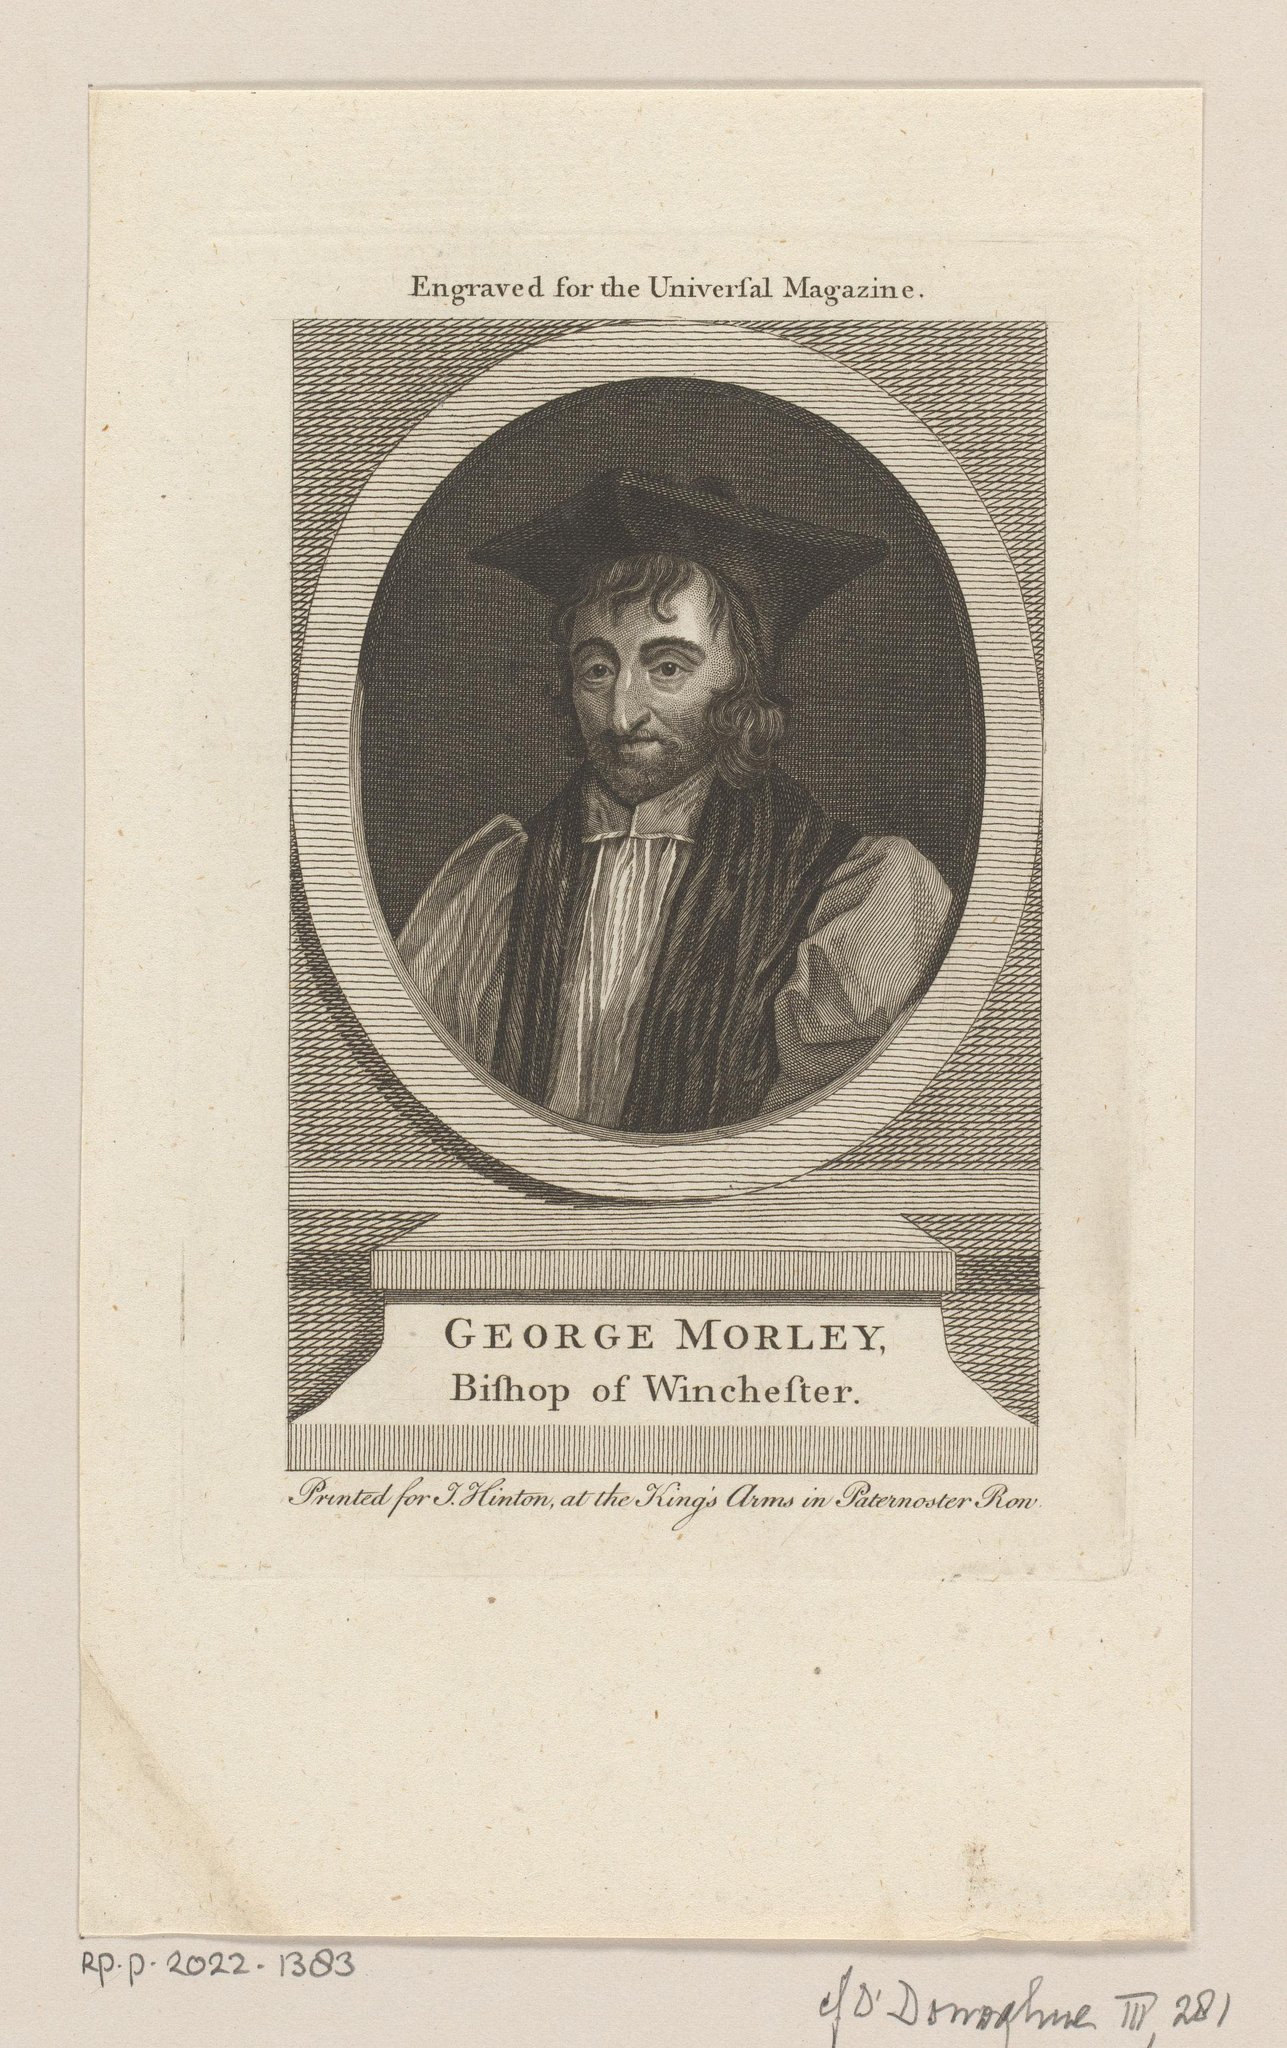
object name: print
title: George Morley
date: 1747-1781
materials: paper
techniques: engraving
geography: london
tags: archbishop, bishop, etc. (roman catholic), historical persons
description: Prent uit een uitgave van Universal Magazine.